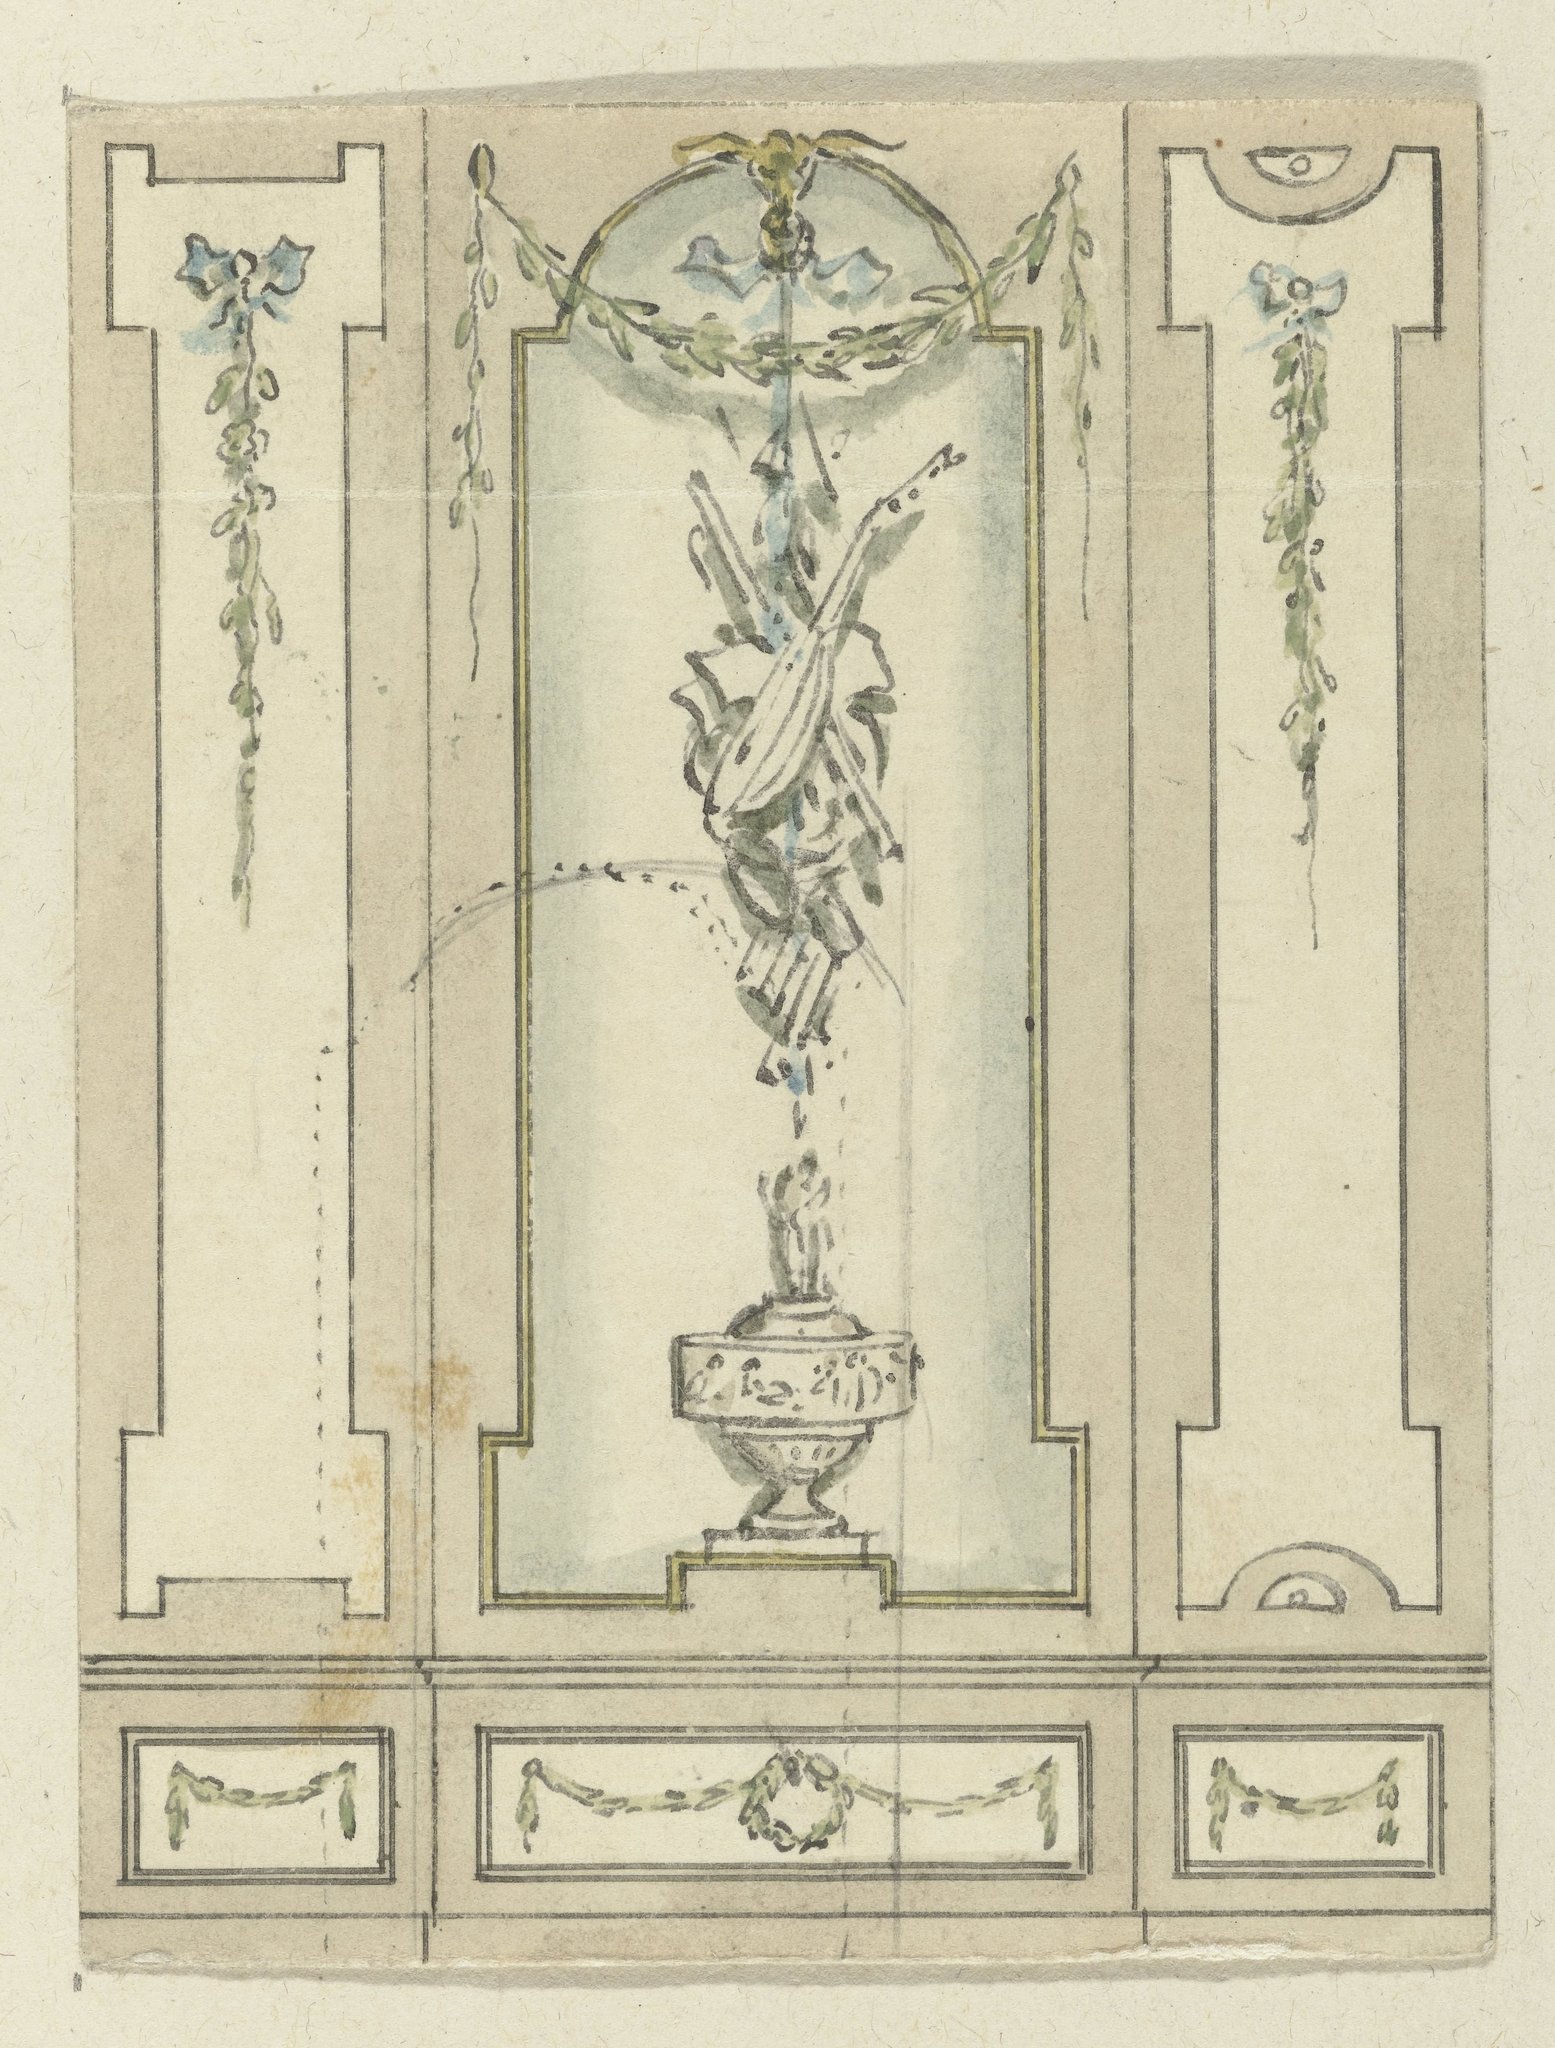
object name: drawing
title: Ontwerp voor een kabinetje bij Arent van Hasselt, Keizersgracht 584, Amsterdam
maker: jurriaan andriessen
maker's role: draughtsman, painter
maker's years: 1742-1819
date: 1783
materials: ink, paper, pencil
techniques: brush, pen